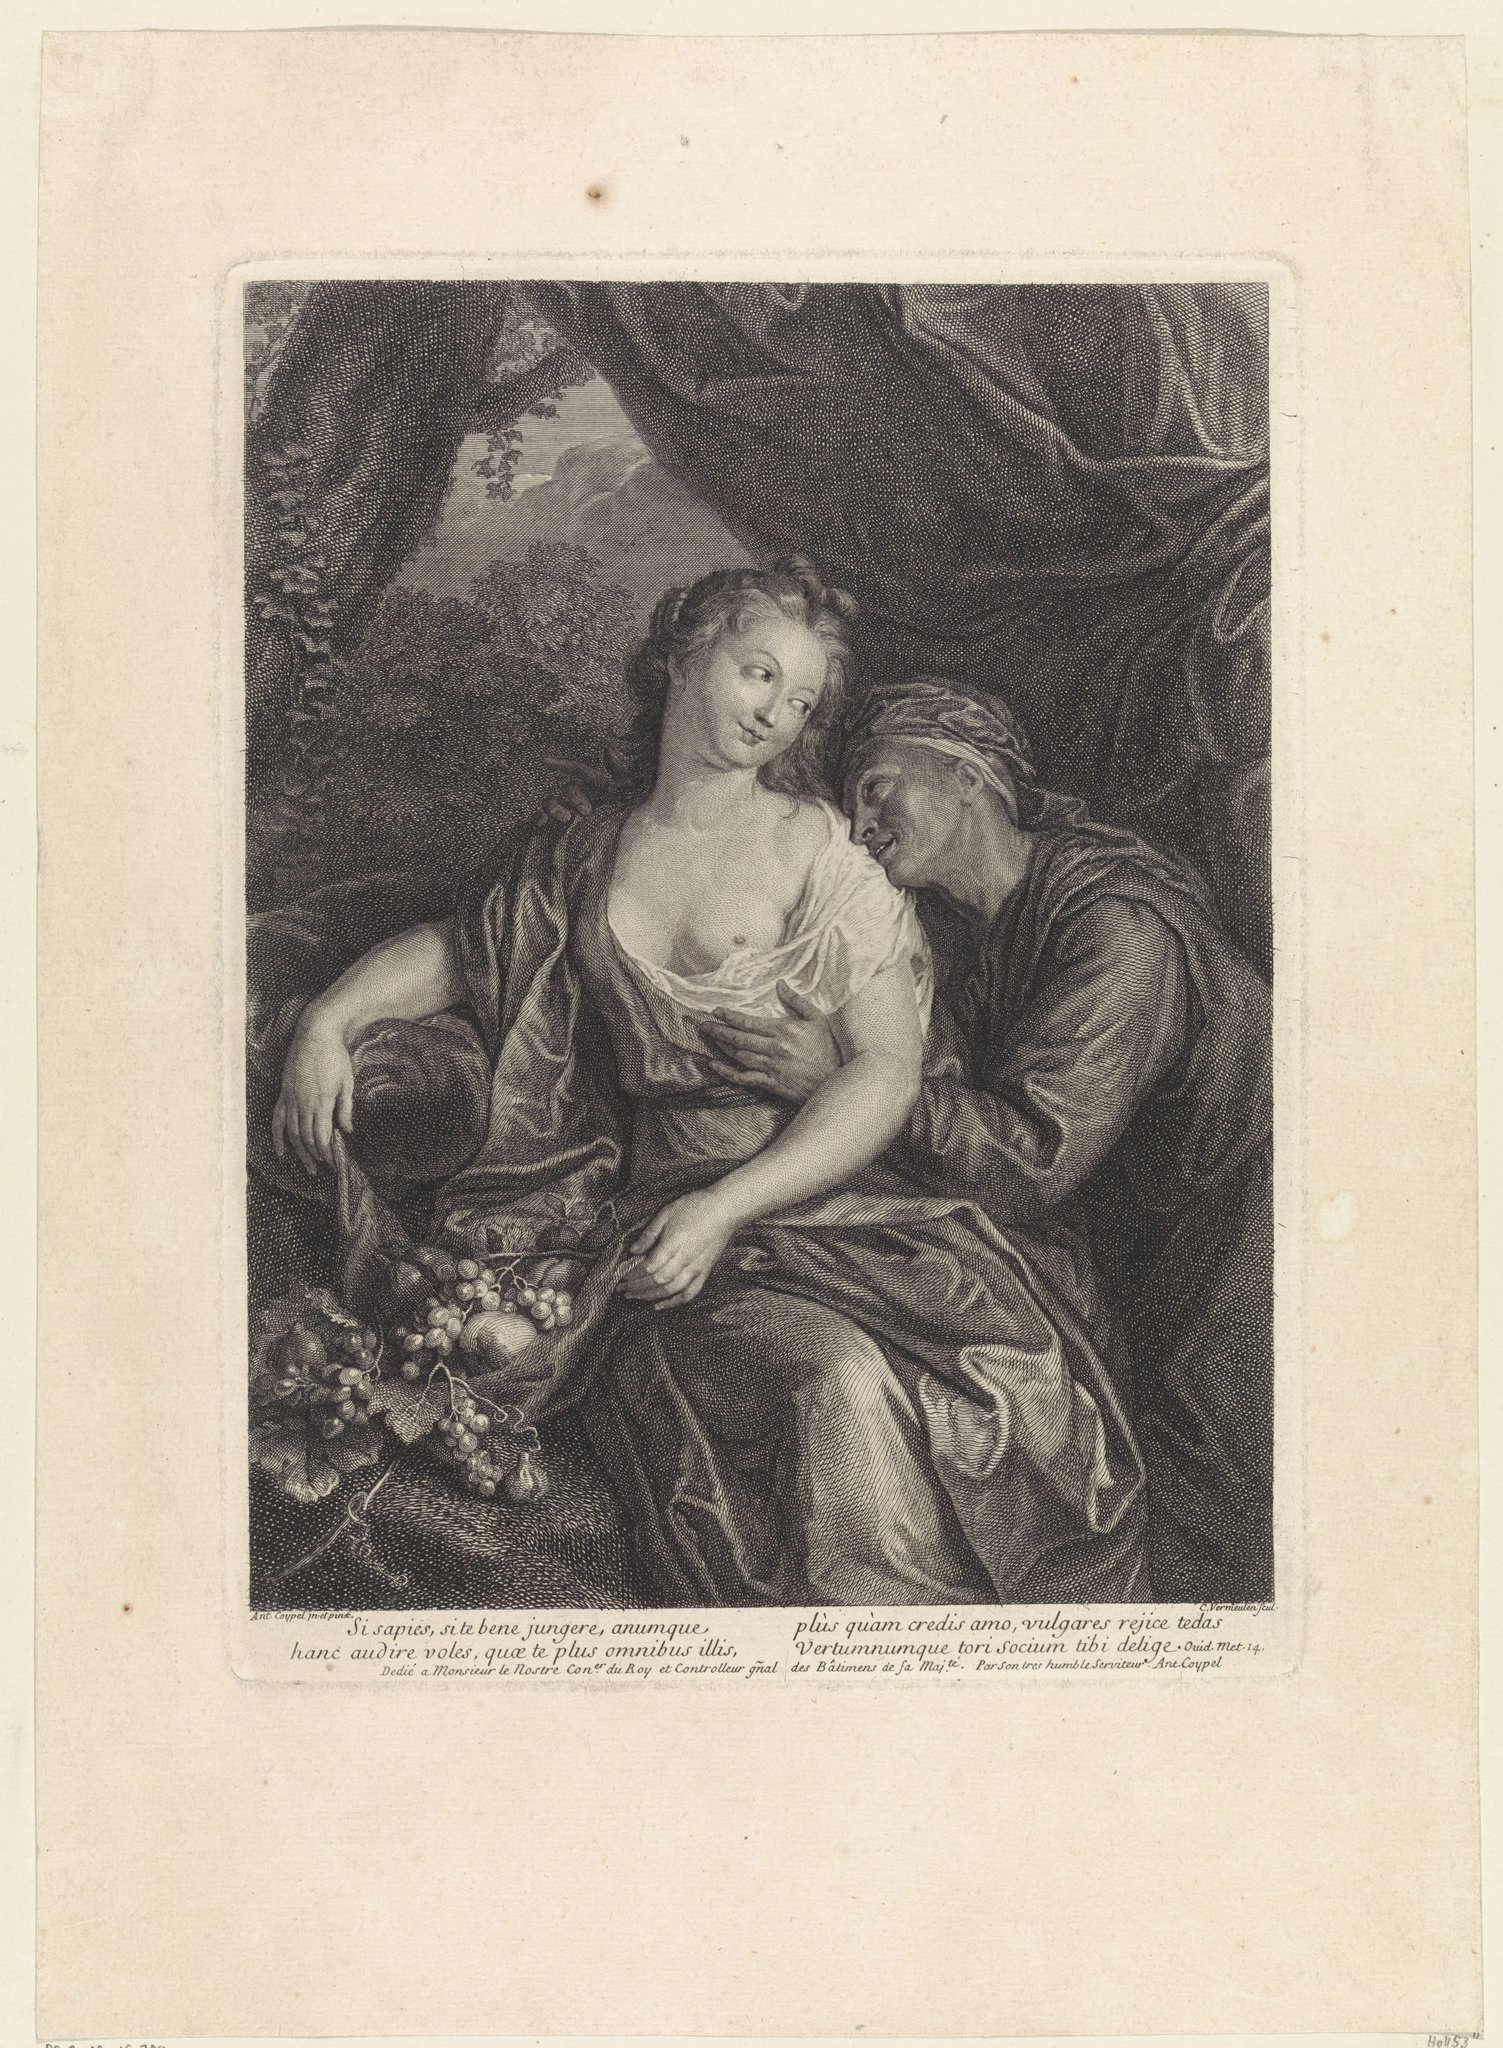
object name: print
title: Vertumnus en Pomona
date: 1654-1709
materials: paper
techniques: engraving, etching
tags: vertumnus and pomona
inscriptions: collector's mark: Lugt 240